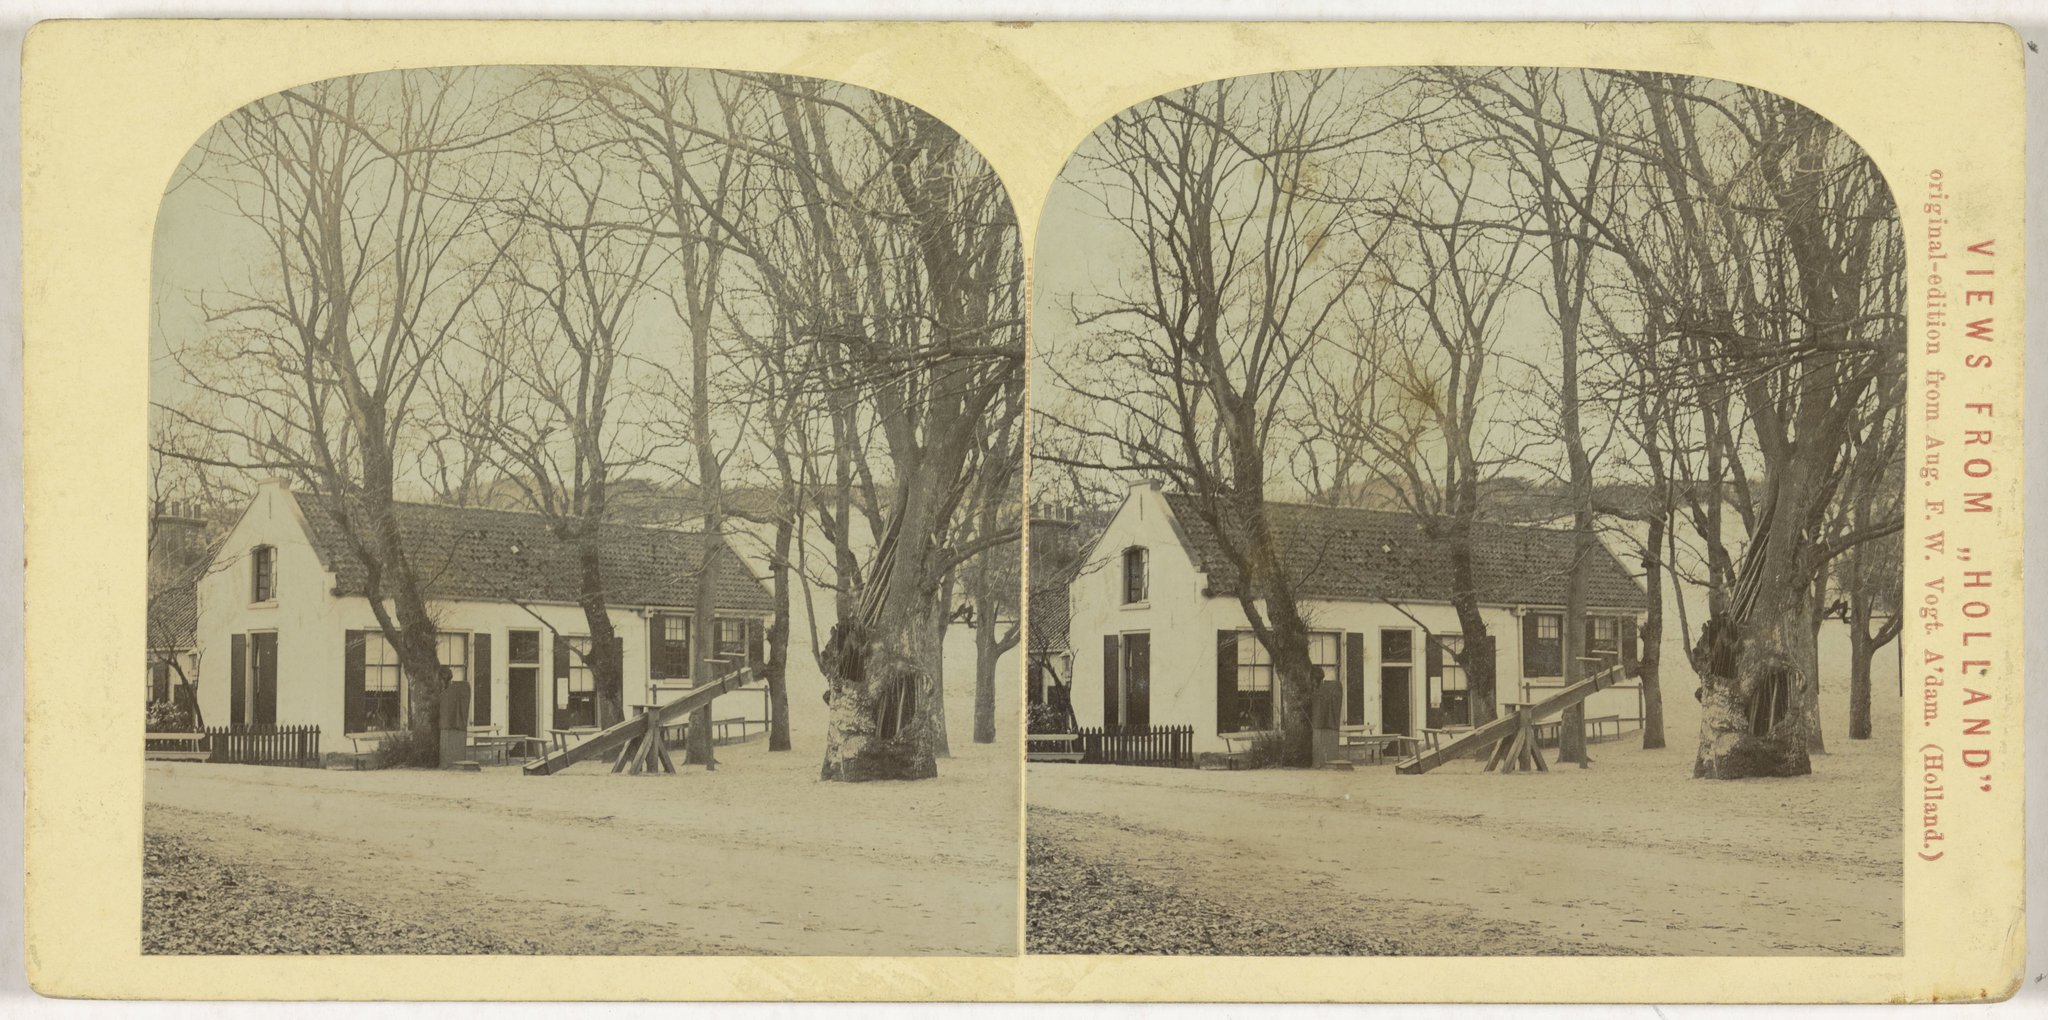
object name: stereograph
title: Kraantje Lek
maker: august frederik willem vogt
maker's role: fotograaf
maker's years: 1871-1922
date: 1870-1920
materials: cardboard, paper, photographic support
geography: amsterdam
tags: overveen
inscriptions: inscription: ‘VIEWS FROM ''HOLLAND''’, annotation: ‘Kraantje Lek boven Haarlem’